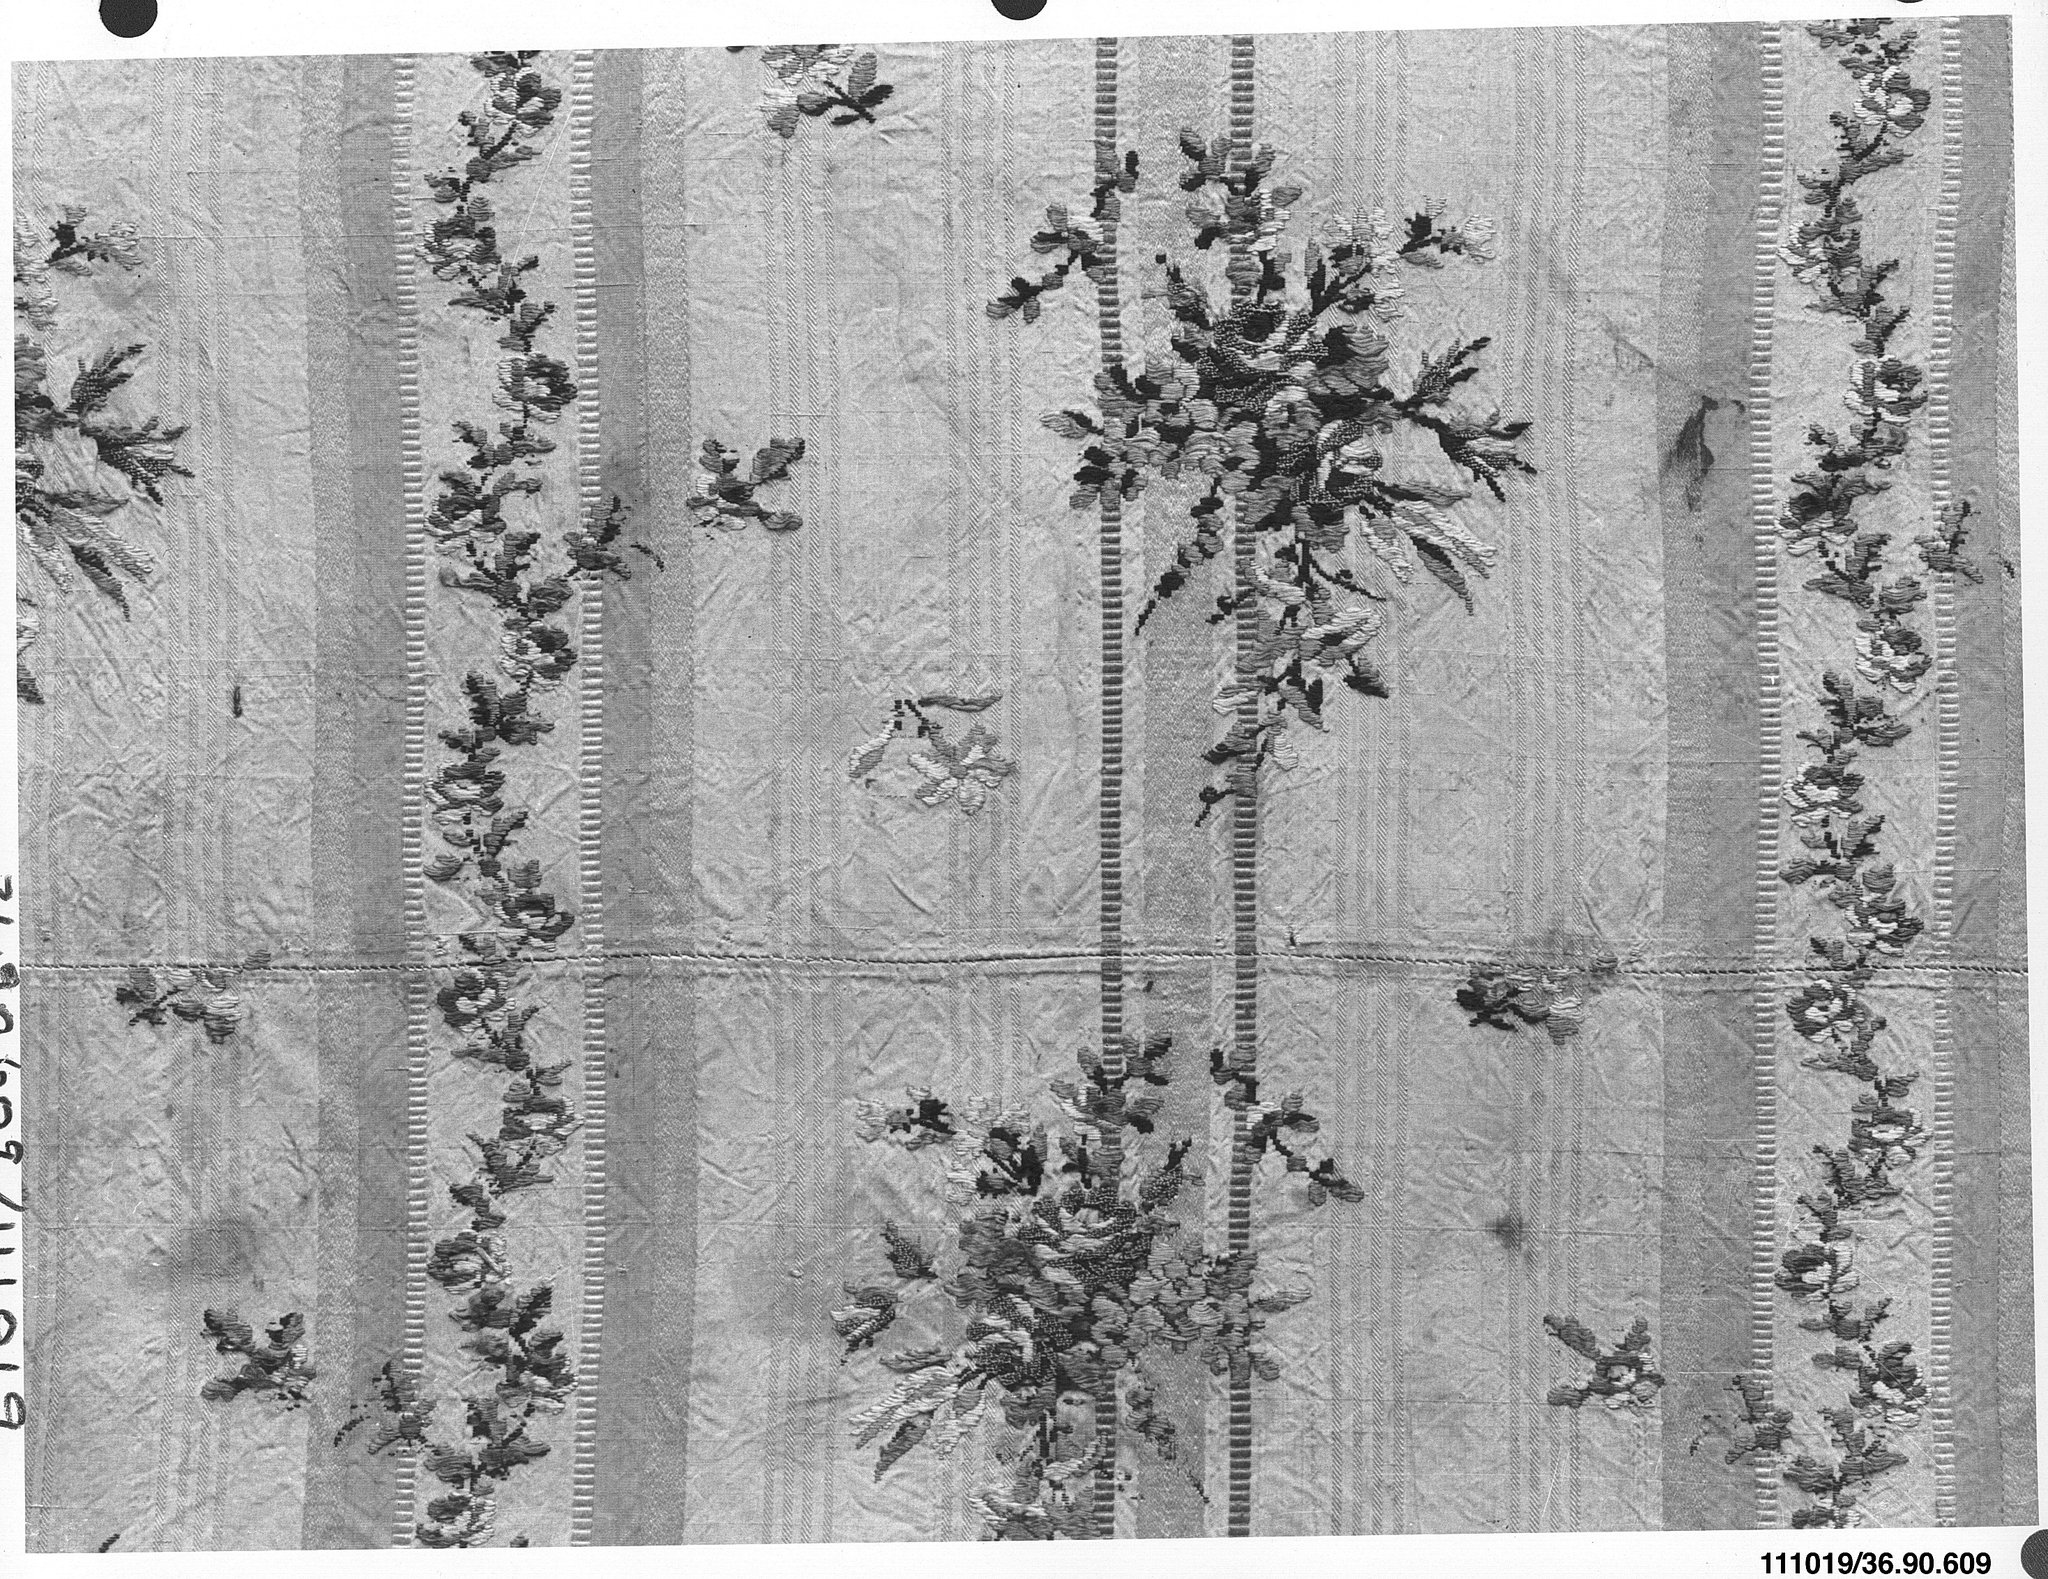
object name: piece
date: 1767-1800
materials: silk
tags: flowers